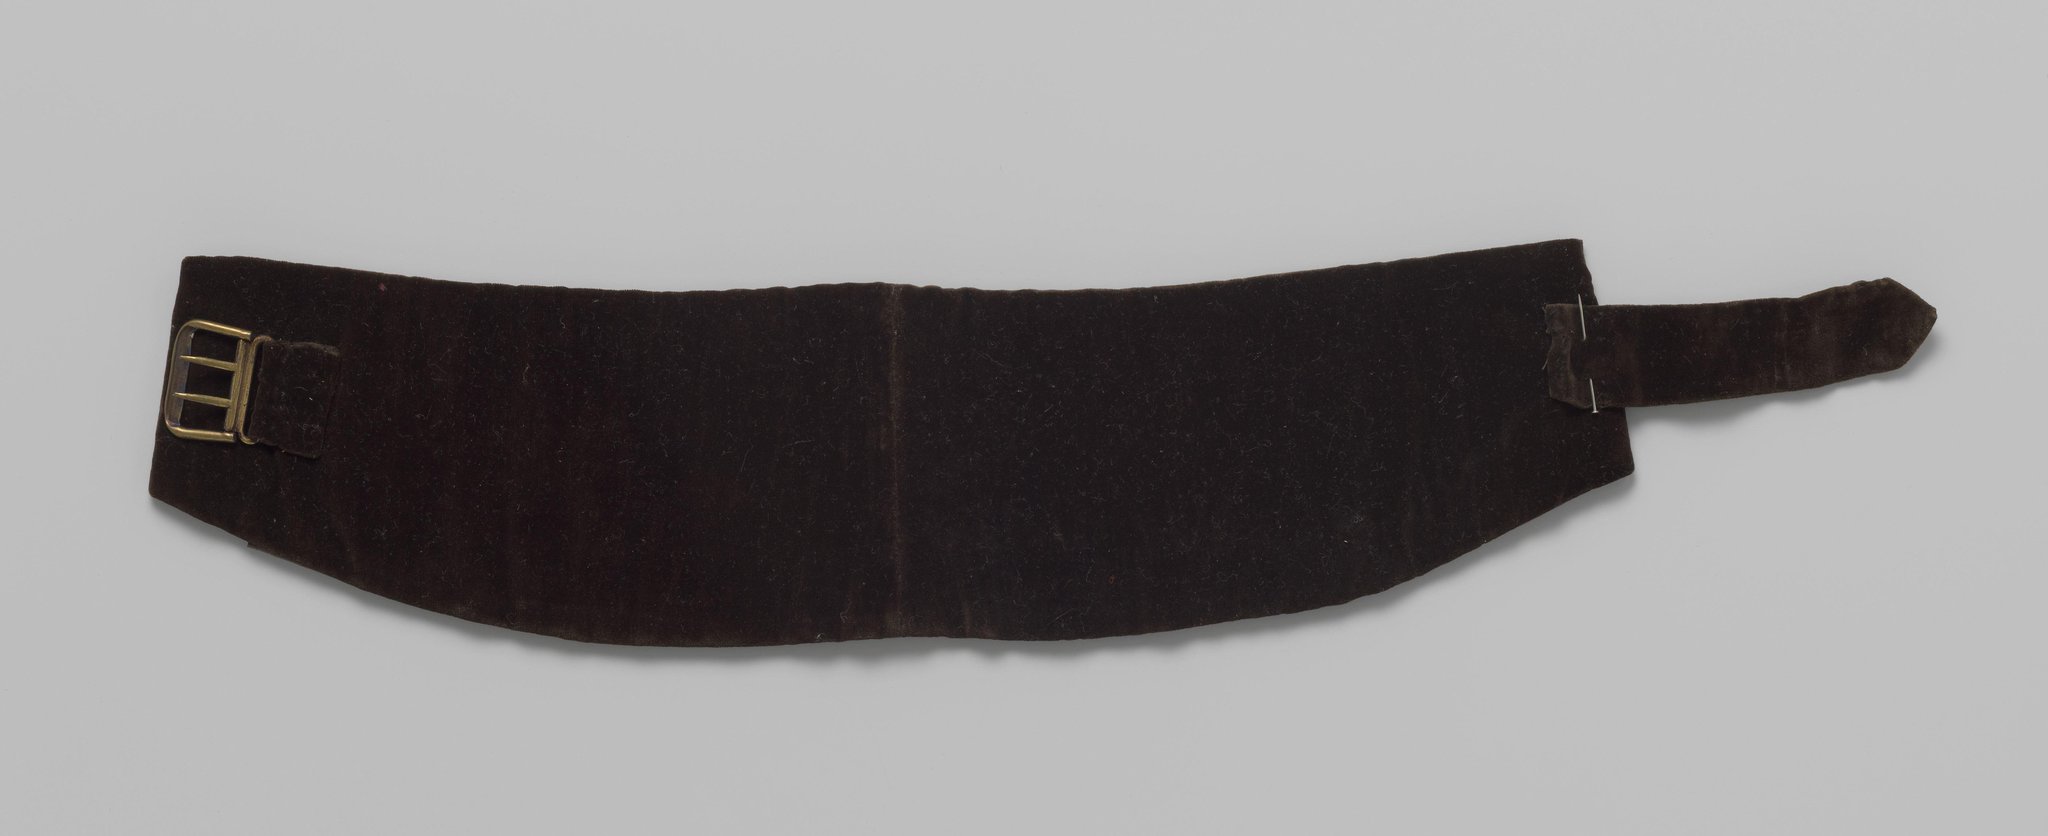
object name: clothing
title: Riem van zwart fluweel met gesp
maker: Anonymous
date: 1840-1930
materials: metal, velvet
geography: europe